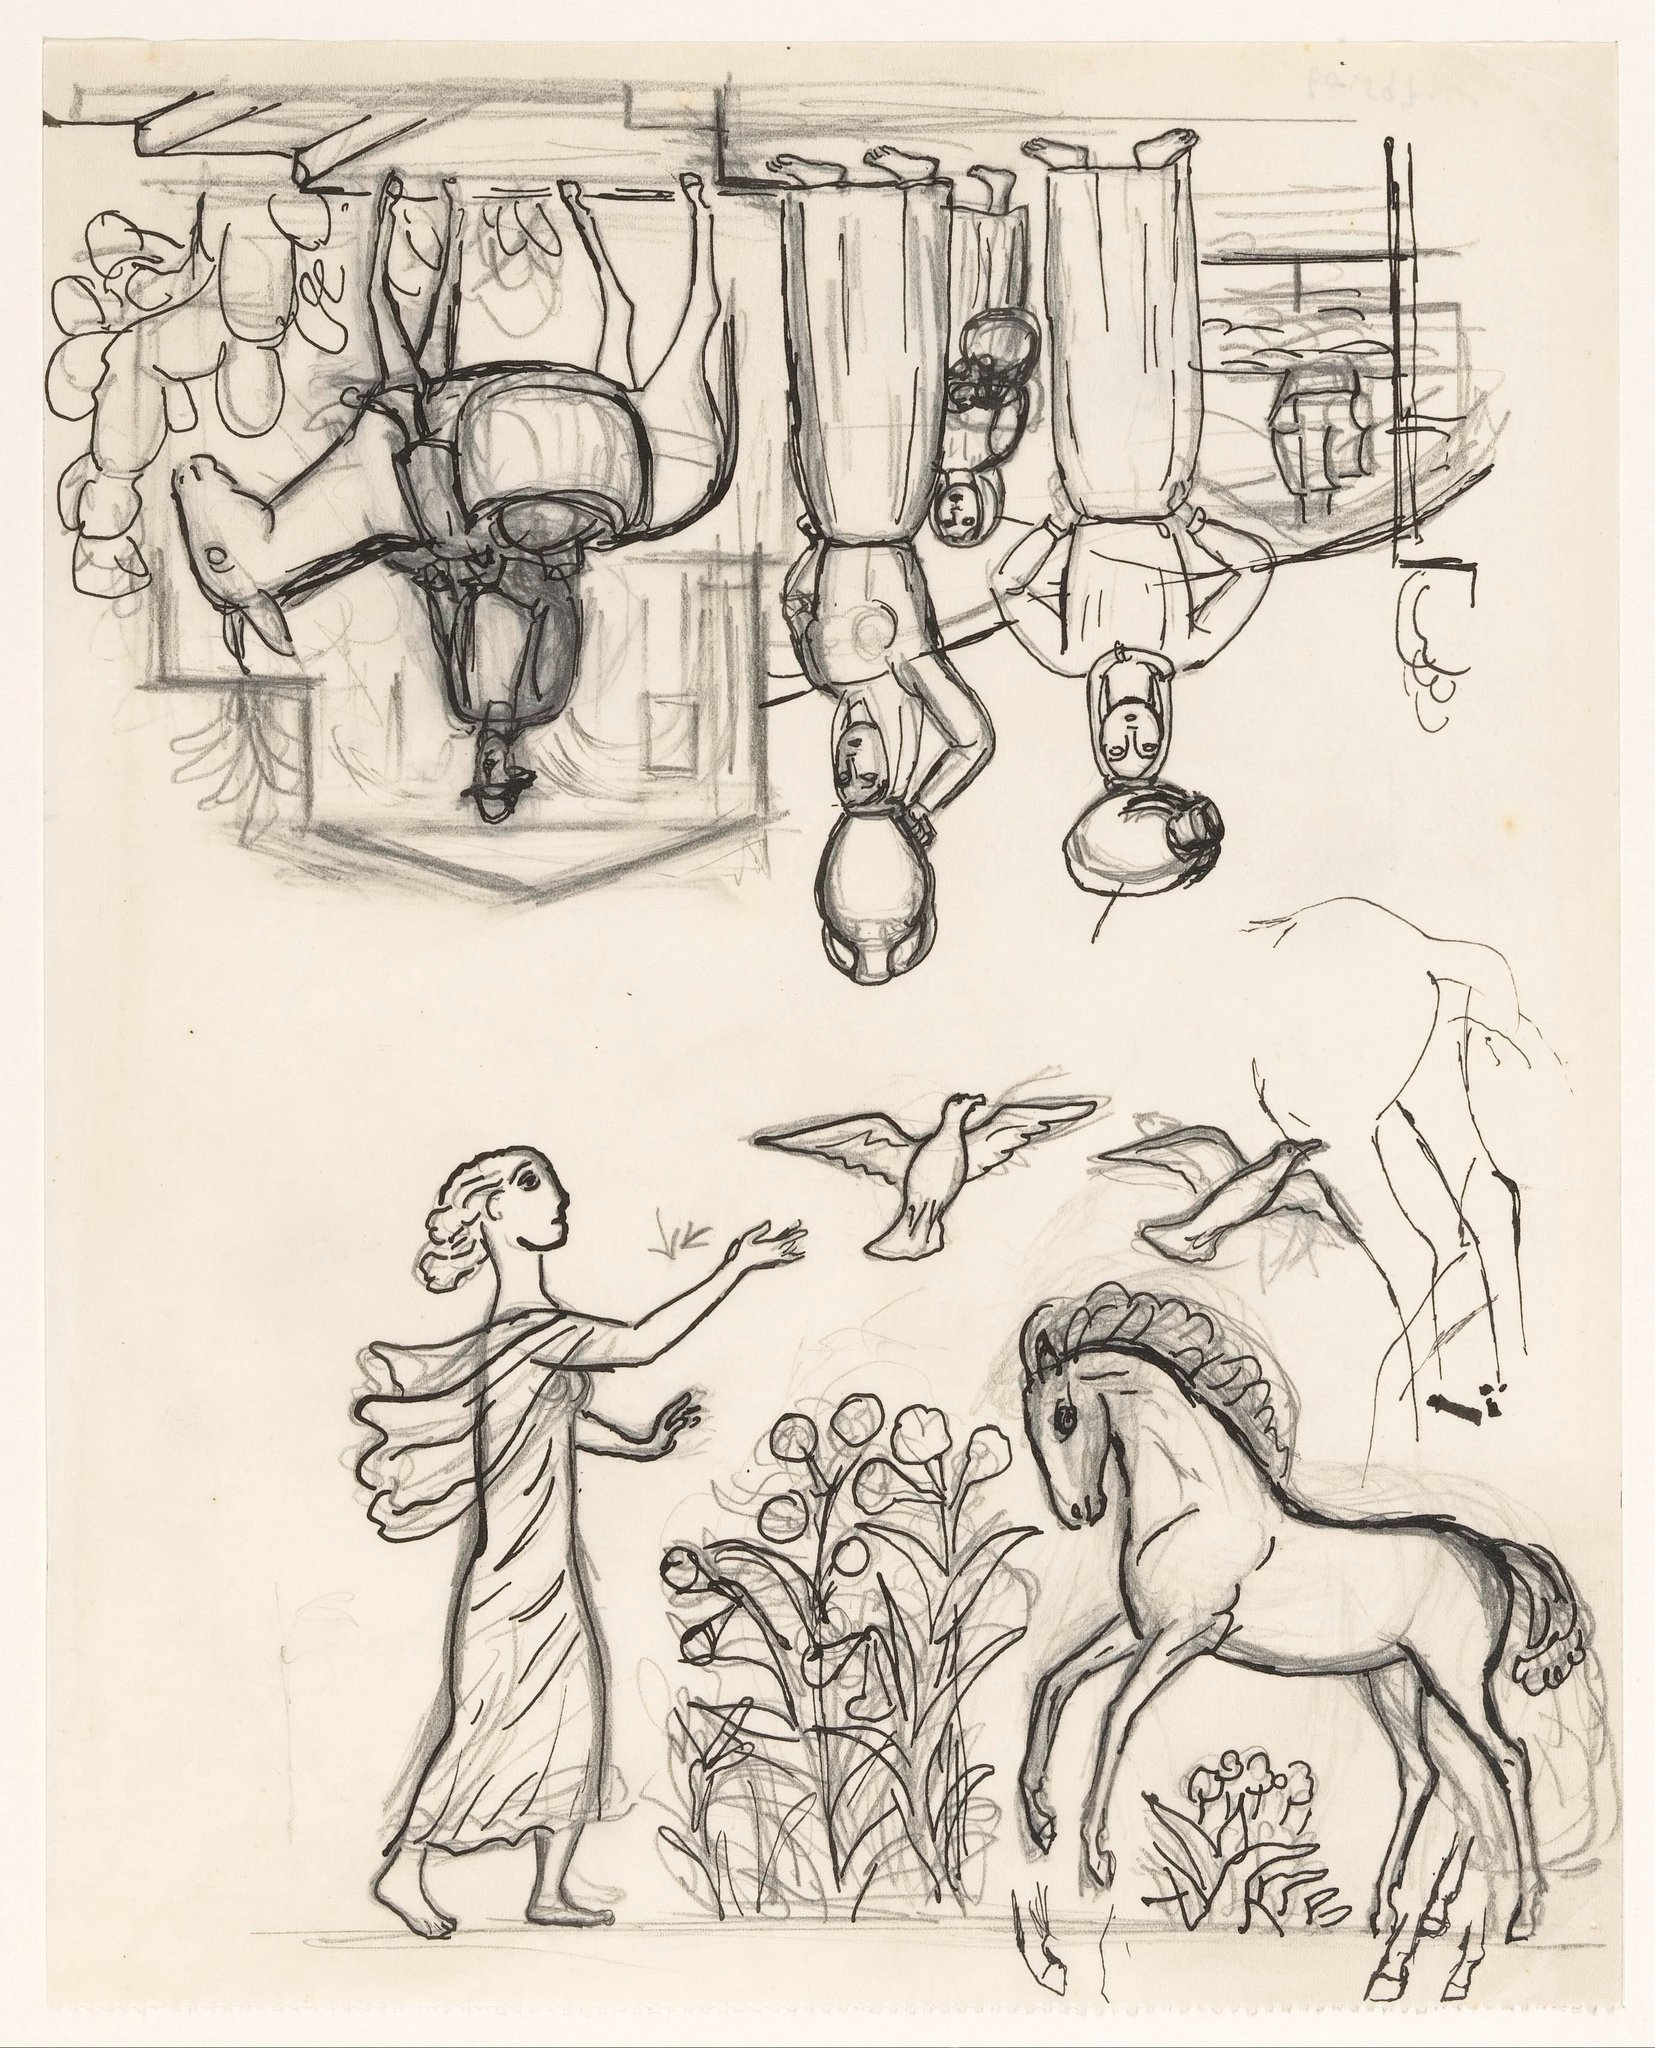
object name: drawing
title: Studieblad met twee vrouwen met kruiken op het hoofd, een man op een ezel en een vrouw die vogels loslaat bij een veulen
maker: leo gestel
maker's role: draughtsman, print maker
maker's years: 1881-1941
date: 1891-1941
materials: ink, paper, pencil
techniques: pen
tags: riding a horse, ass, or mule; rider, horseman, birds, female sex; woman, horse, container of ceramics: jar, jug, pot, vase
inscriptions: watermark: ‘GW/ PAPIER/ 1671’, collector's mark: Lugt 2228